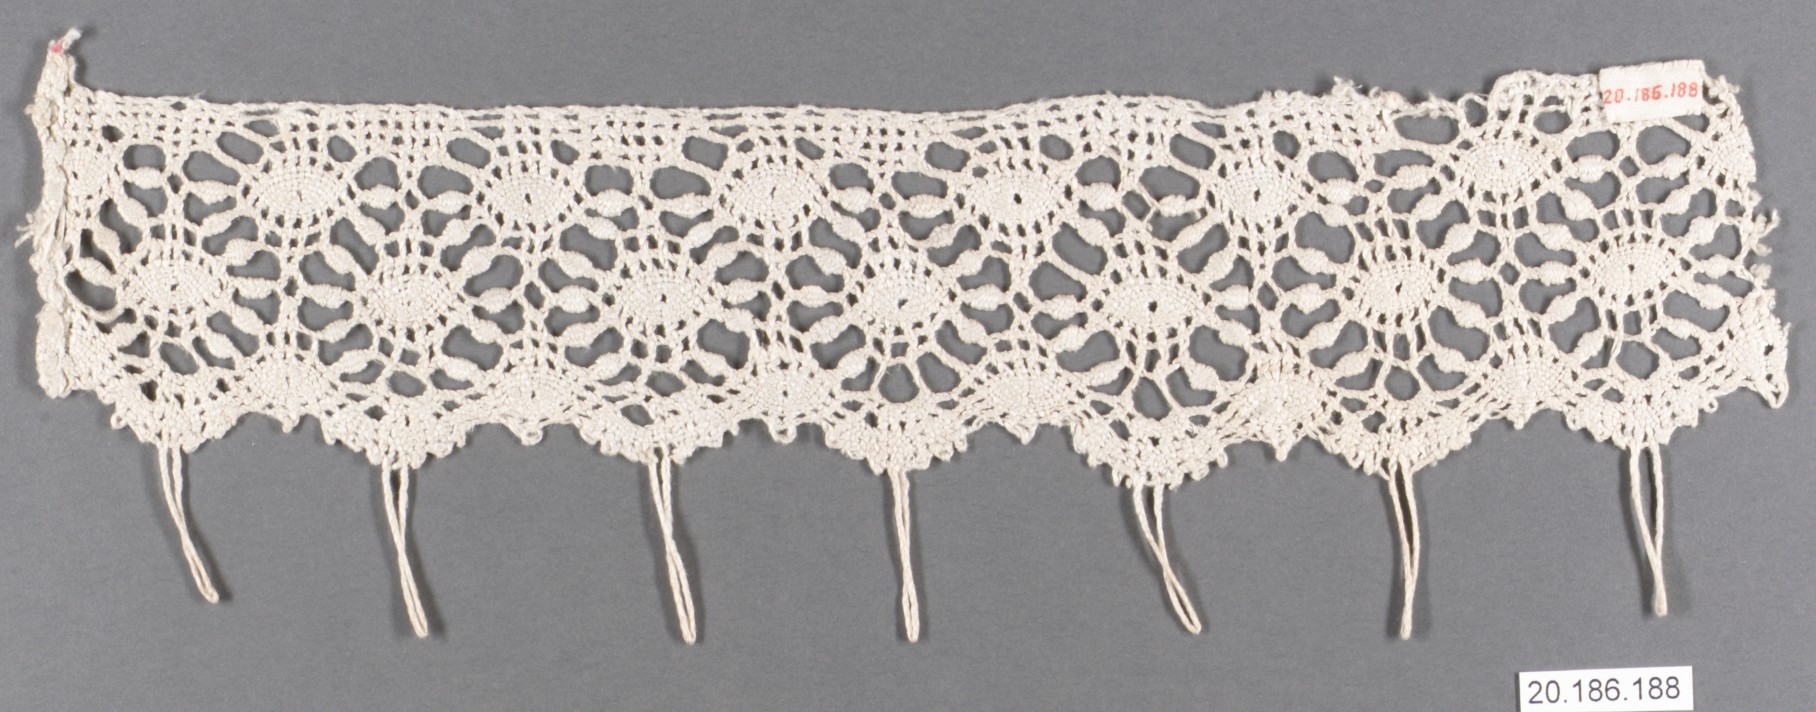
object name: edging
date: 1501-1550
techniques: lace